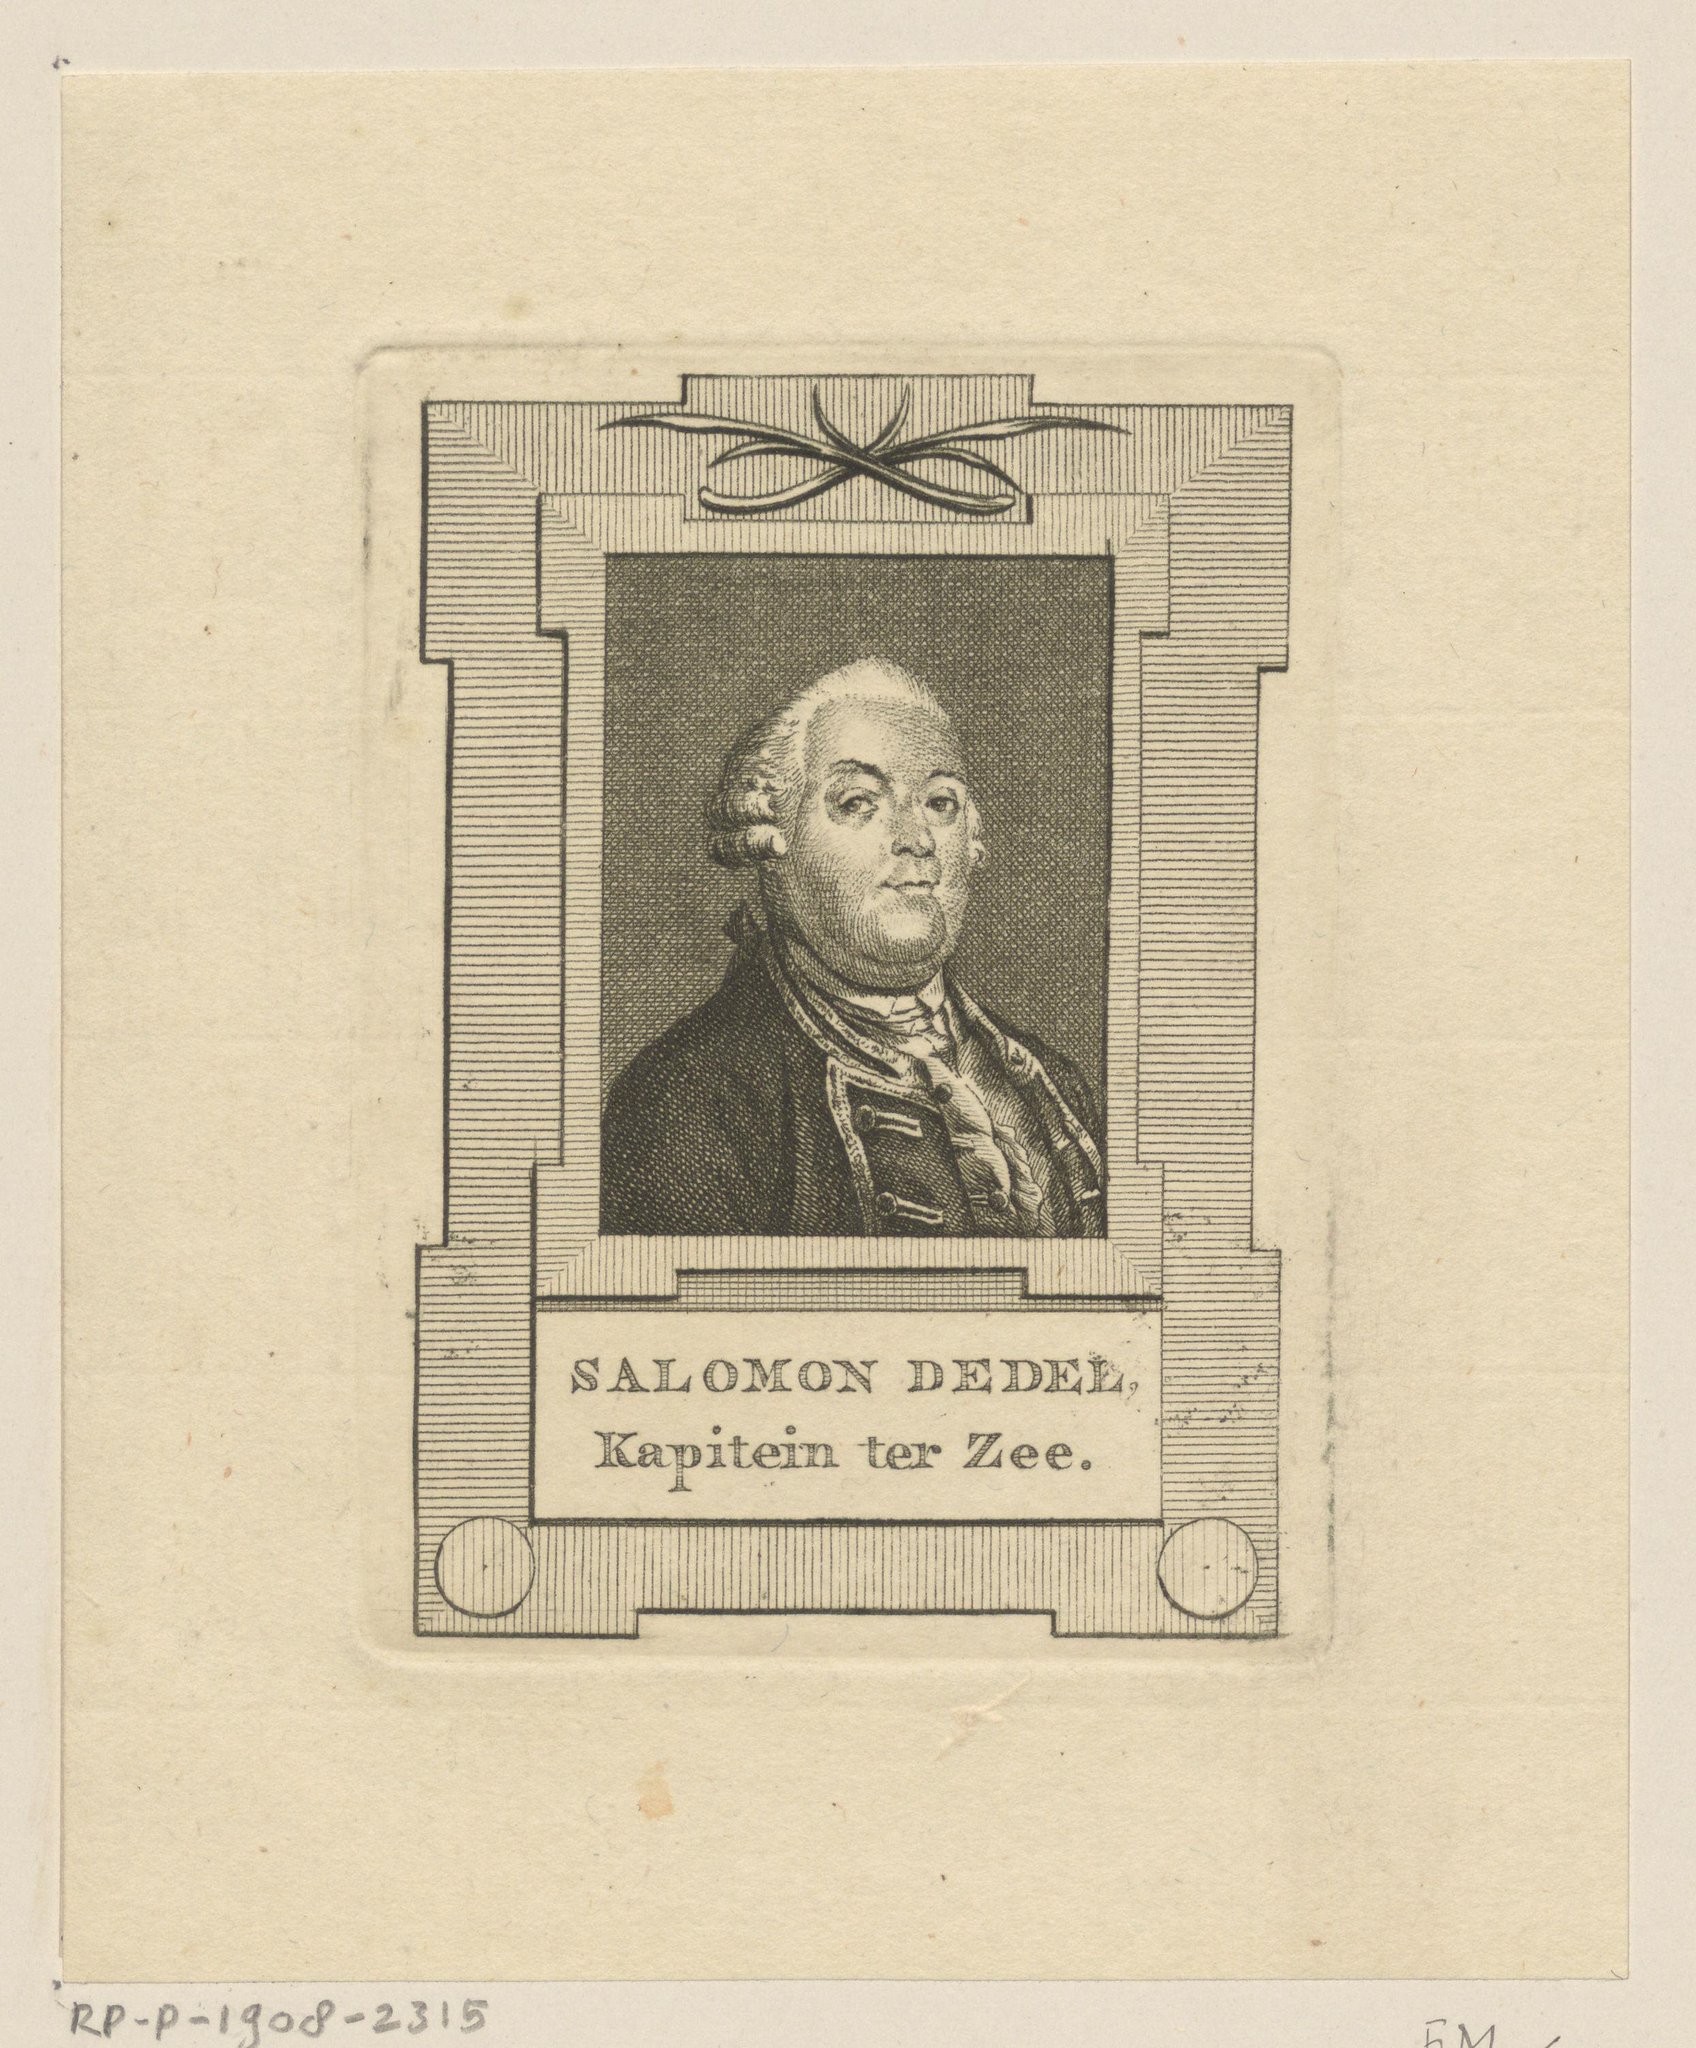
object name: print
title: Portret van Salomon Dedel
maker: Anonymous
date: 1772-1799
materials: paper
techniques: engraving, etching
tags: amsterdam, seaman (with name of rank), historical persons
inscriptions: collector's mark: Lugt 2228